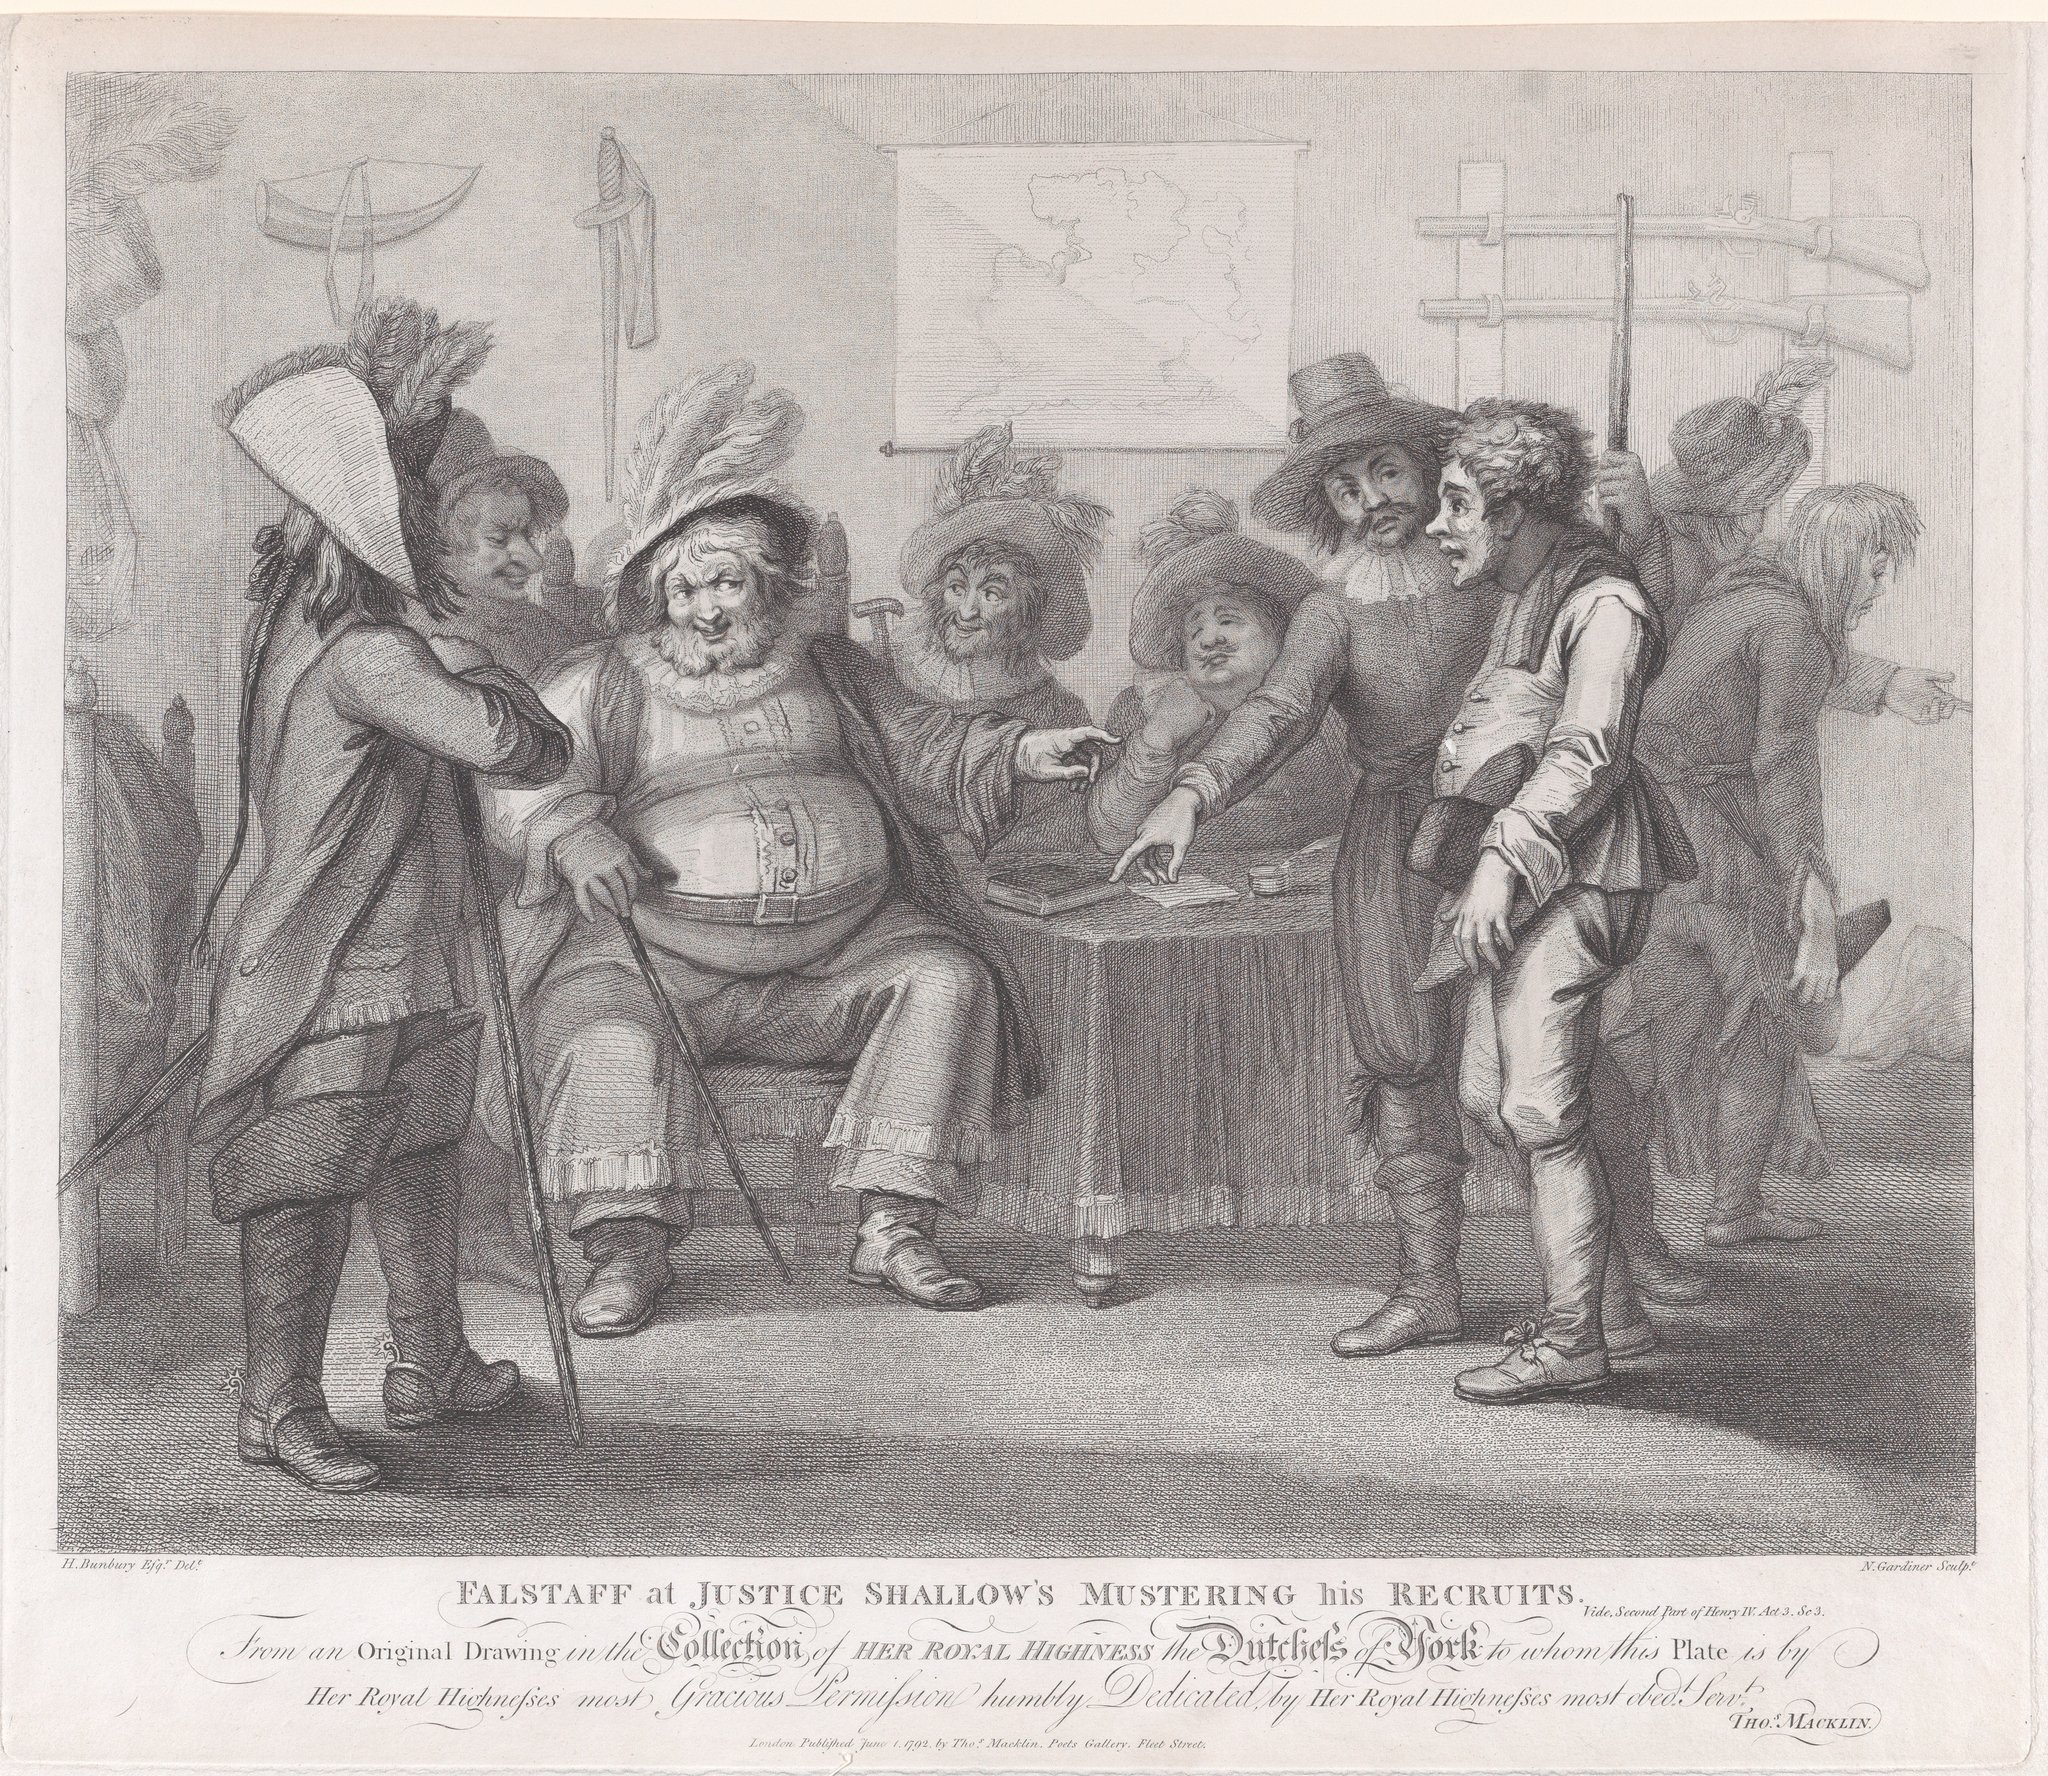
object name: print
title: Falstaff at Justice Shallow's Mustering His Recruits (Shakespeare, Henry IV, Part II, Act 3, Scene 2)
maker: william nelson gardiner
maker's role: engraver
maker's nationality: british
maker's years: 1766-1814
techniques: etching, engraving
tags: shakespeare,men